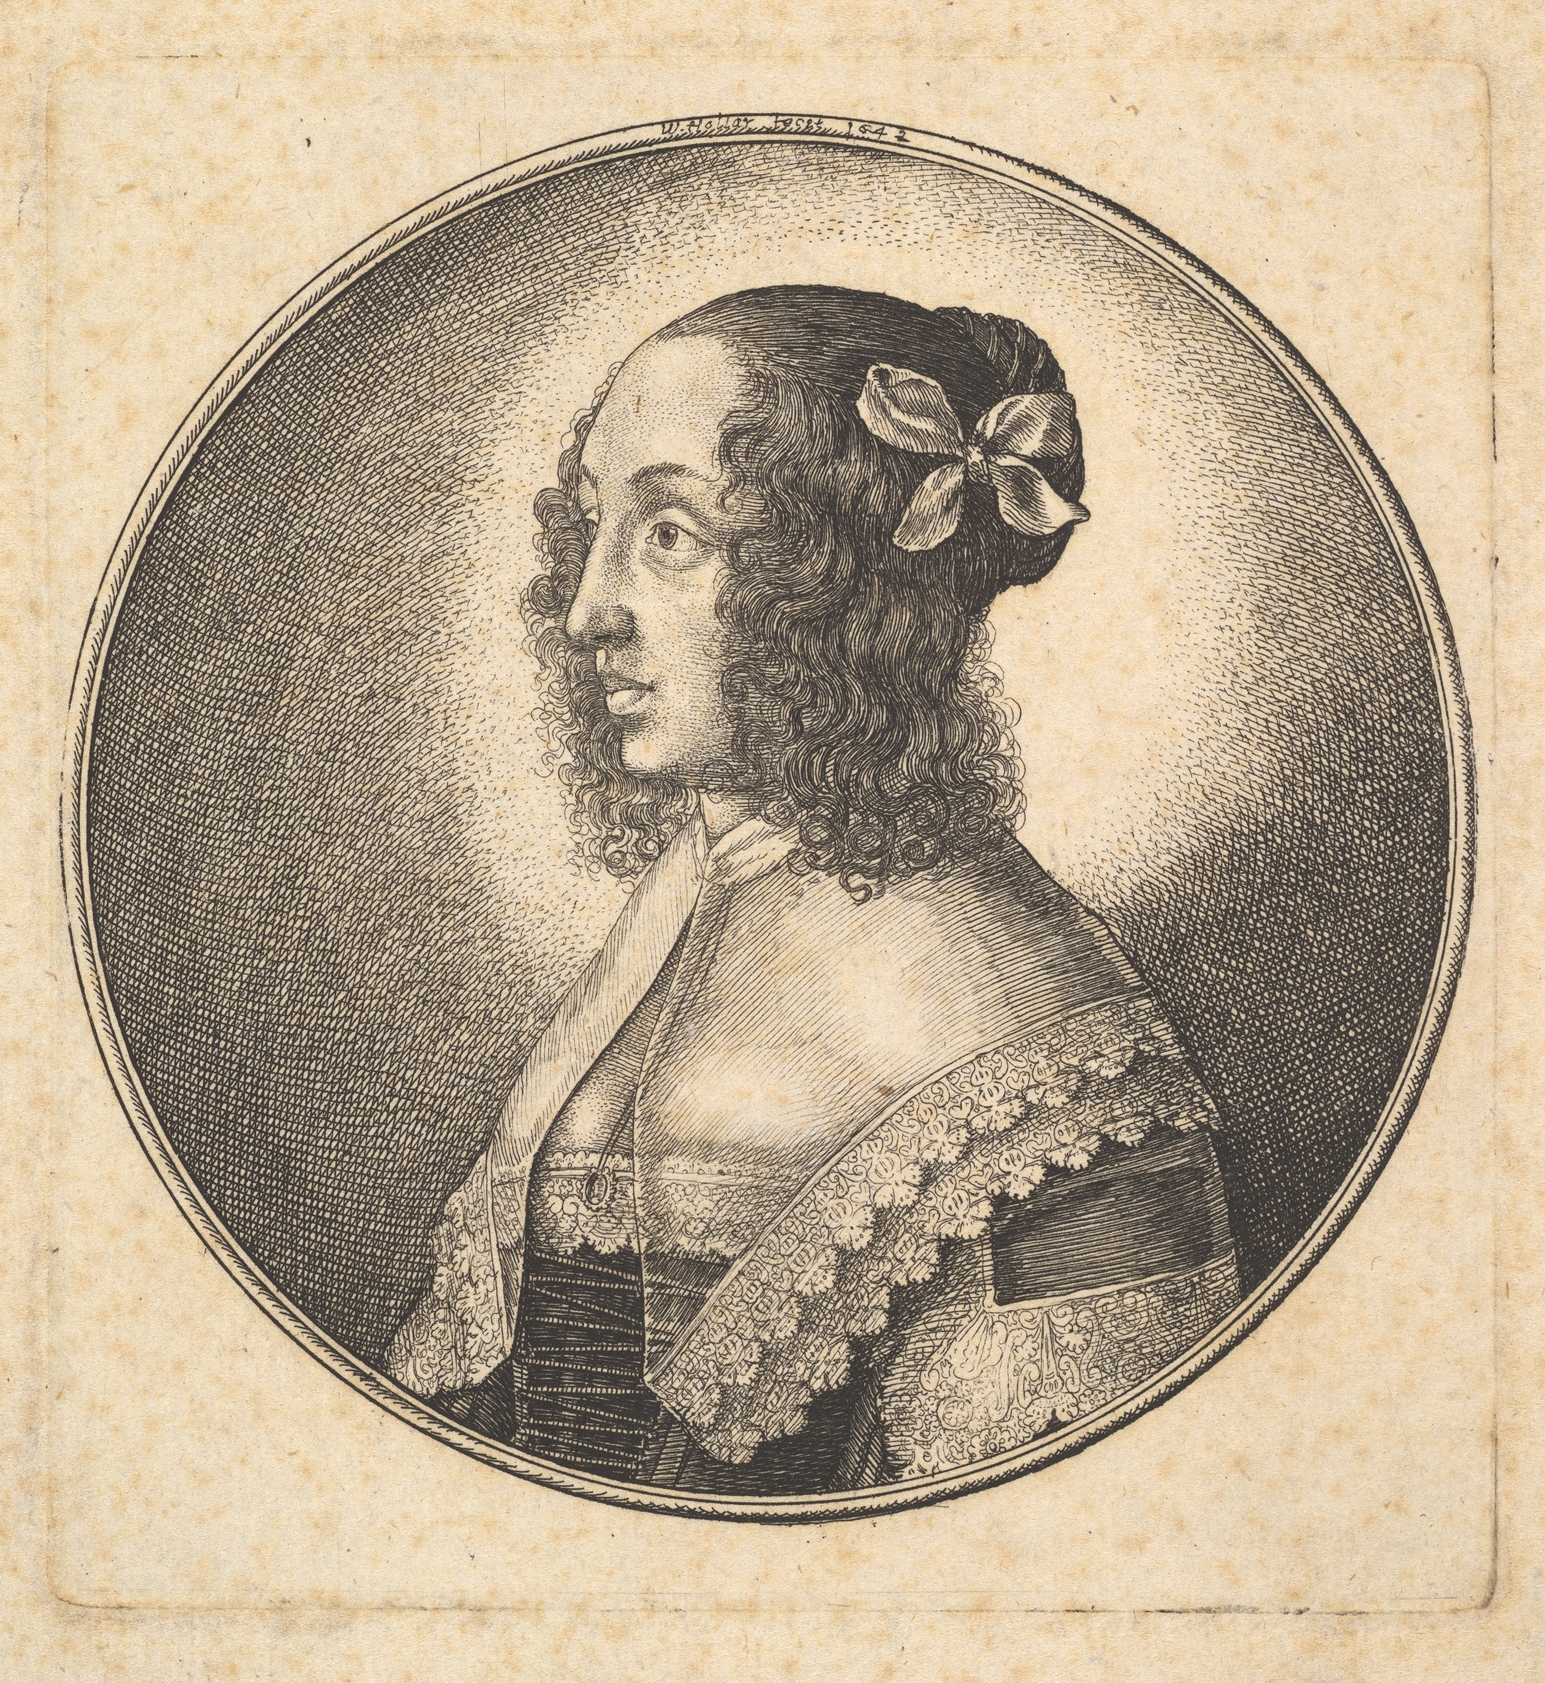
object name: print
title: Woman with dark hair and a bow in profile to the left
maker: wenceslaus hollar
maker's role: artist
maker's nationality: bohemian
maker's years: 1607-1677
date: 1642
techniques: etching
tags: profiles,women